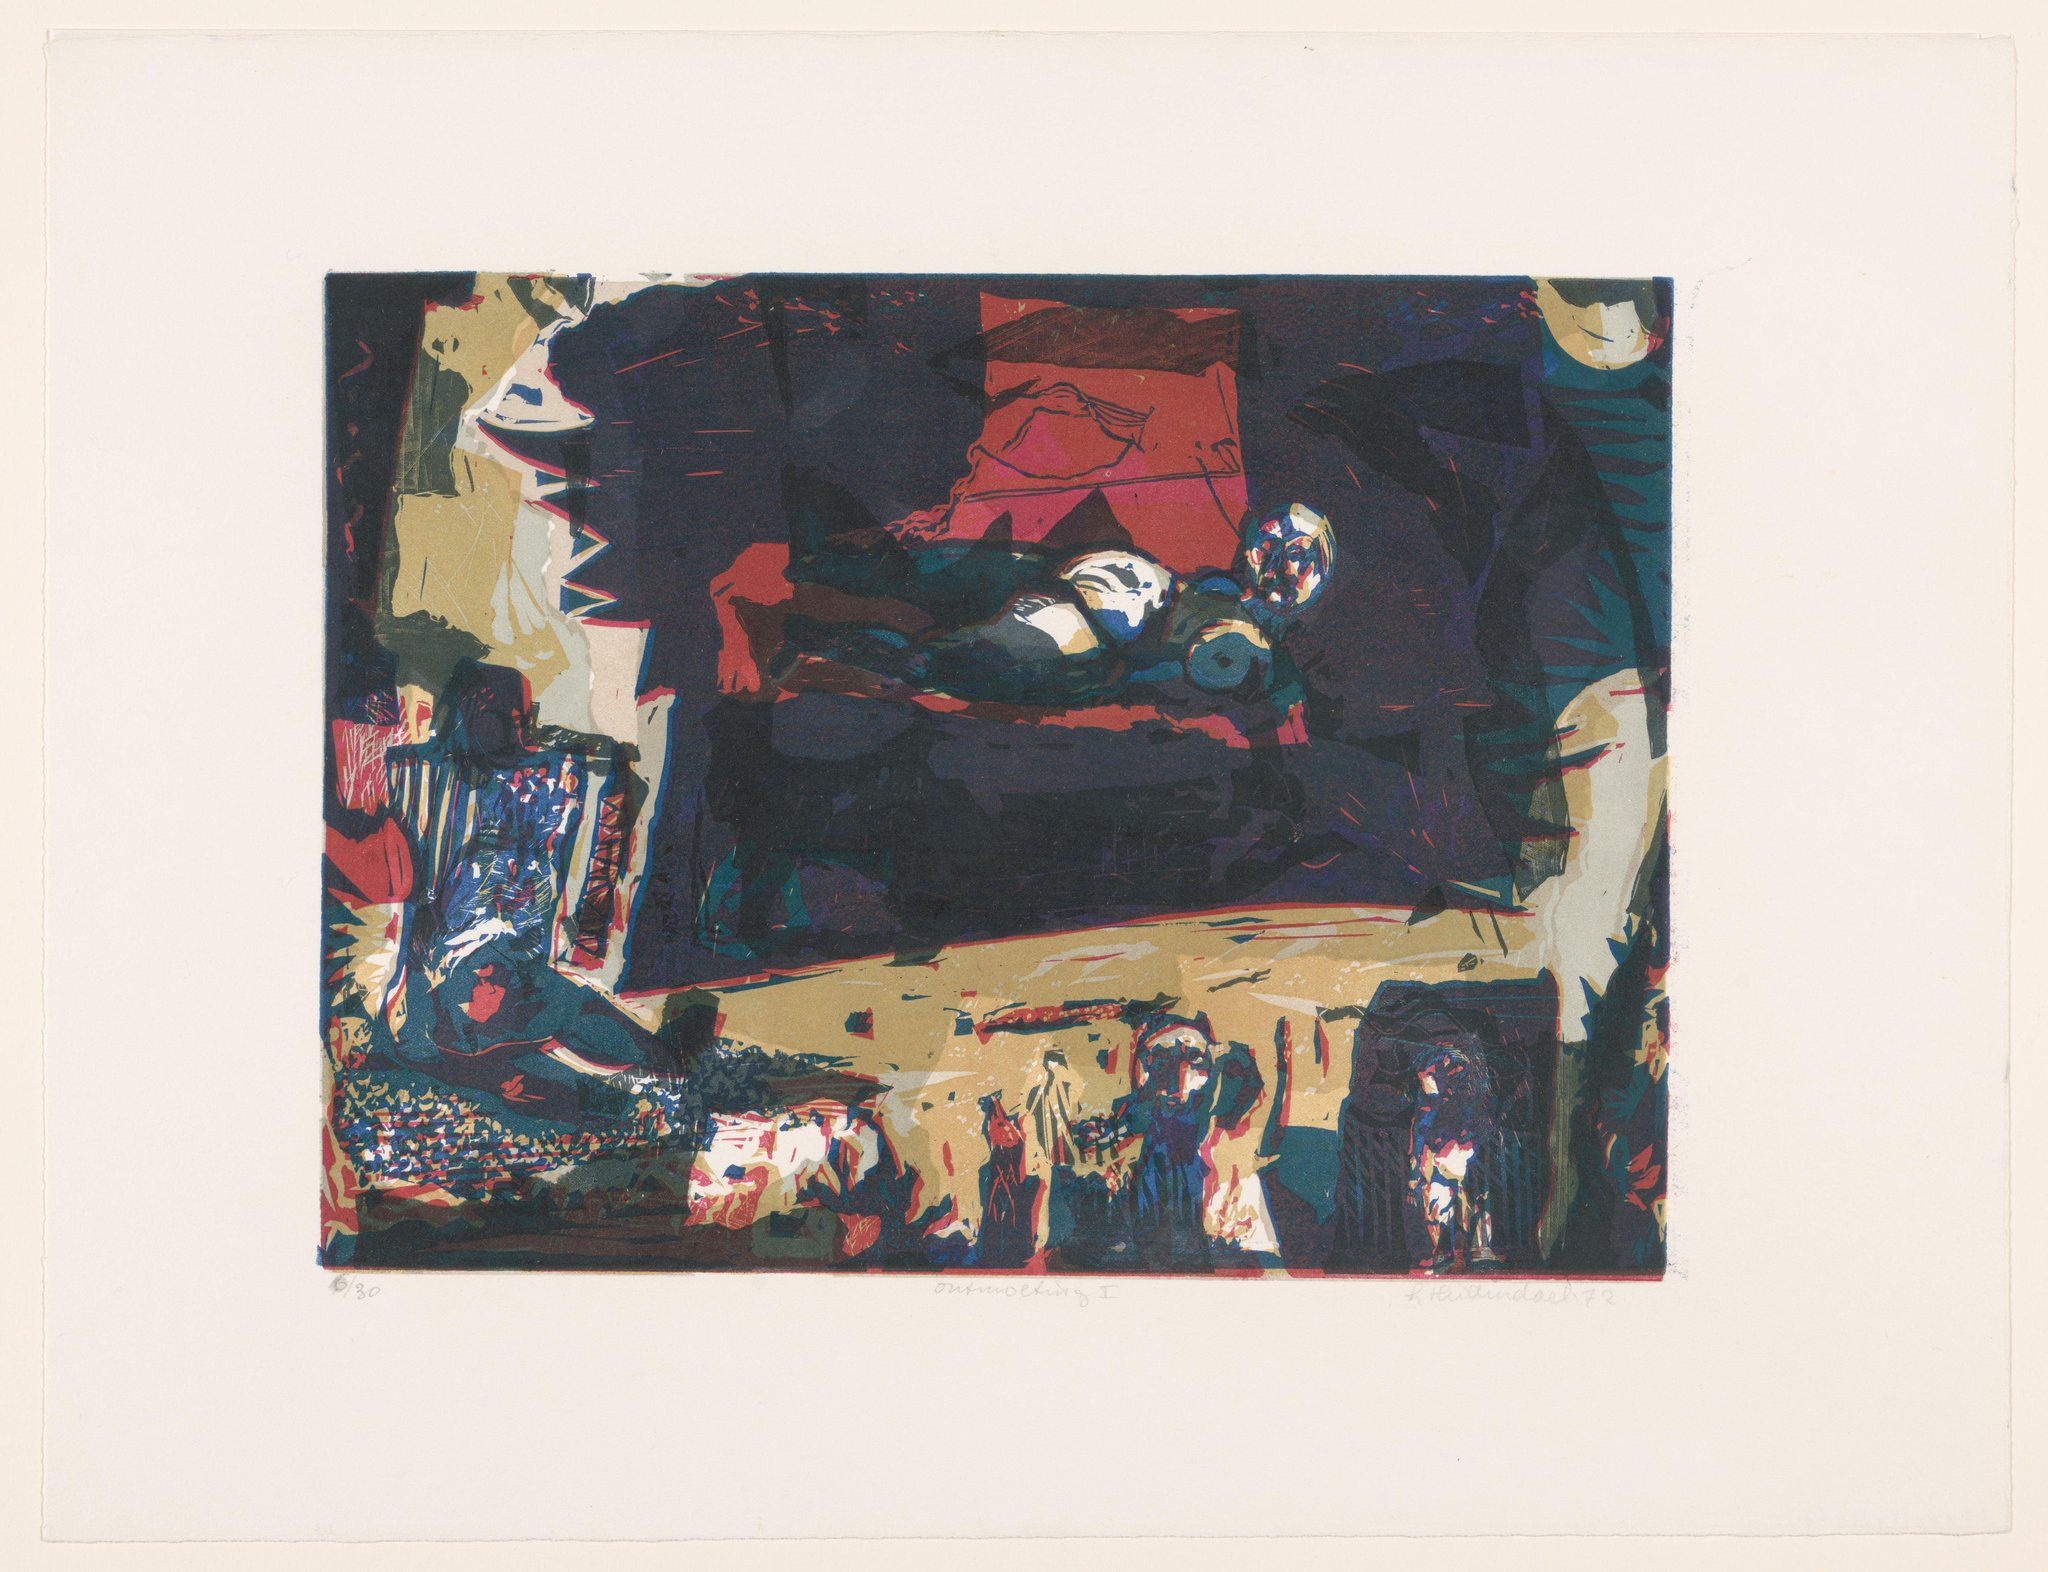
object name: print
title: Ontmoeting I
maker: lau heidendael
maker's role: print maker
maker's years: 1946-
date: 1972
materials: paper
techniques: linocut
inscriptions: title: ‘ontmoeting I’, signature and date: ‘L Heidendael '72’, edition: ‘6/30’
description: Veelkleurige voorstelling met in het midden een liggend naakt.